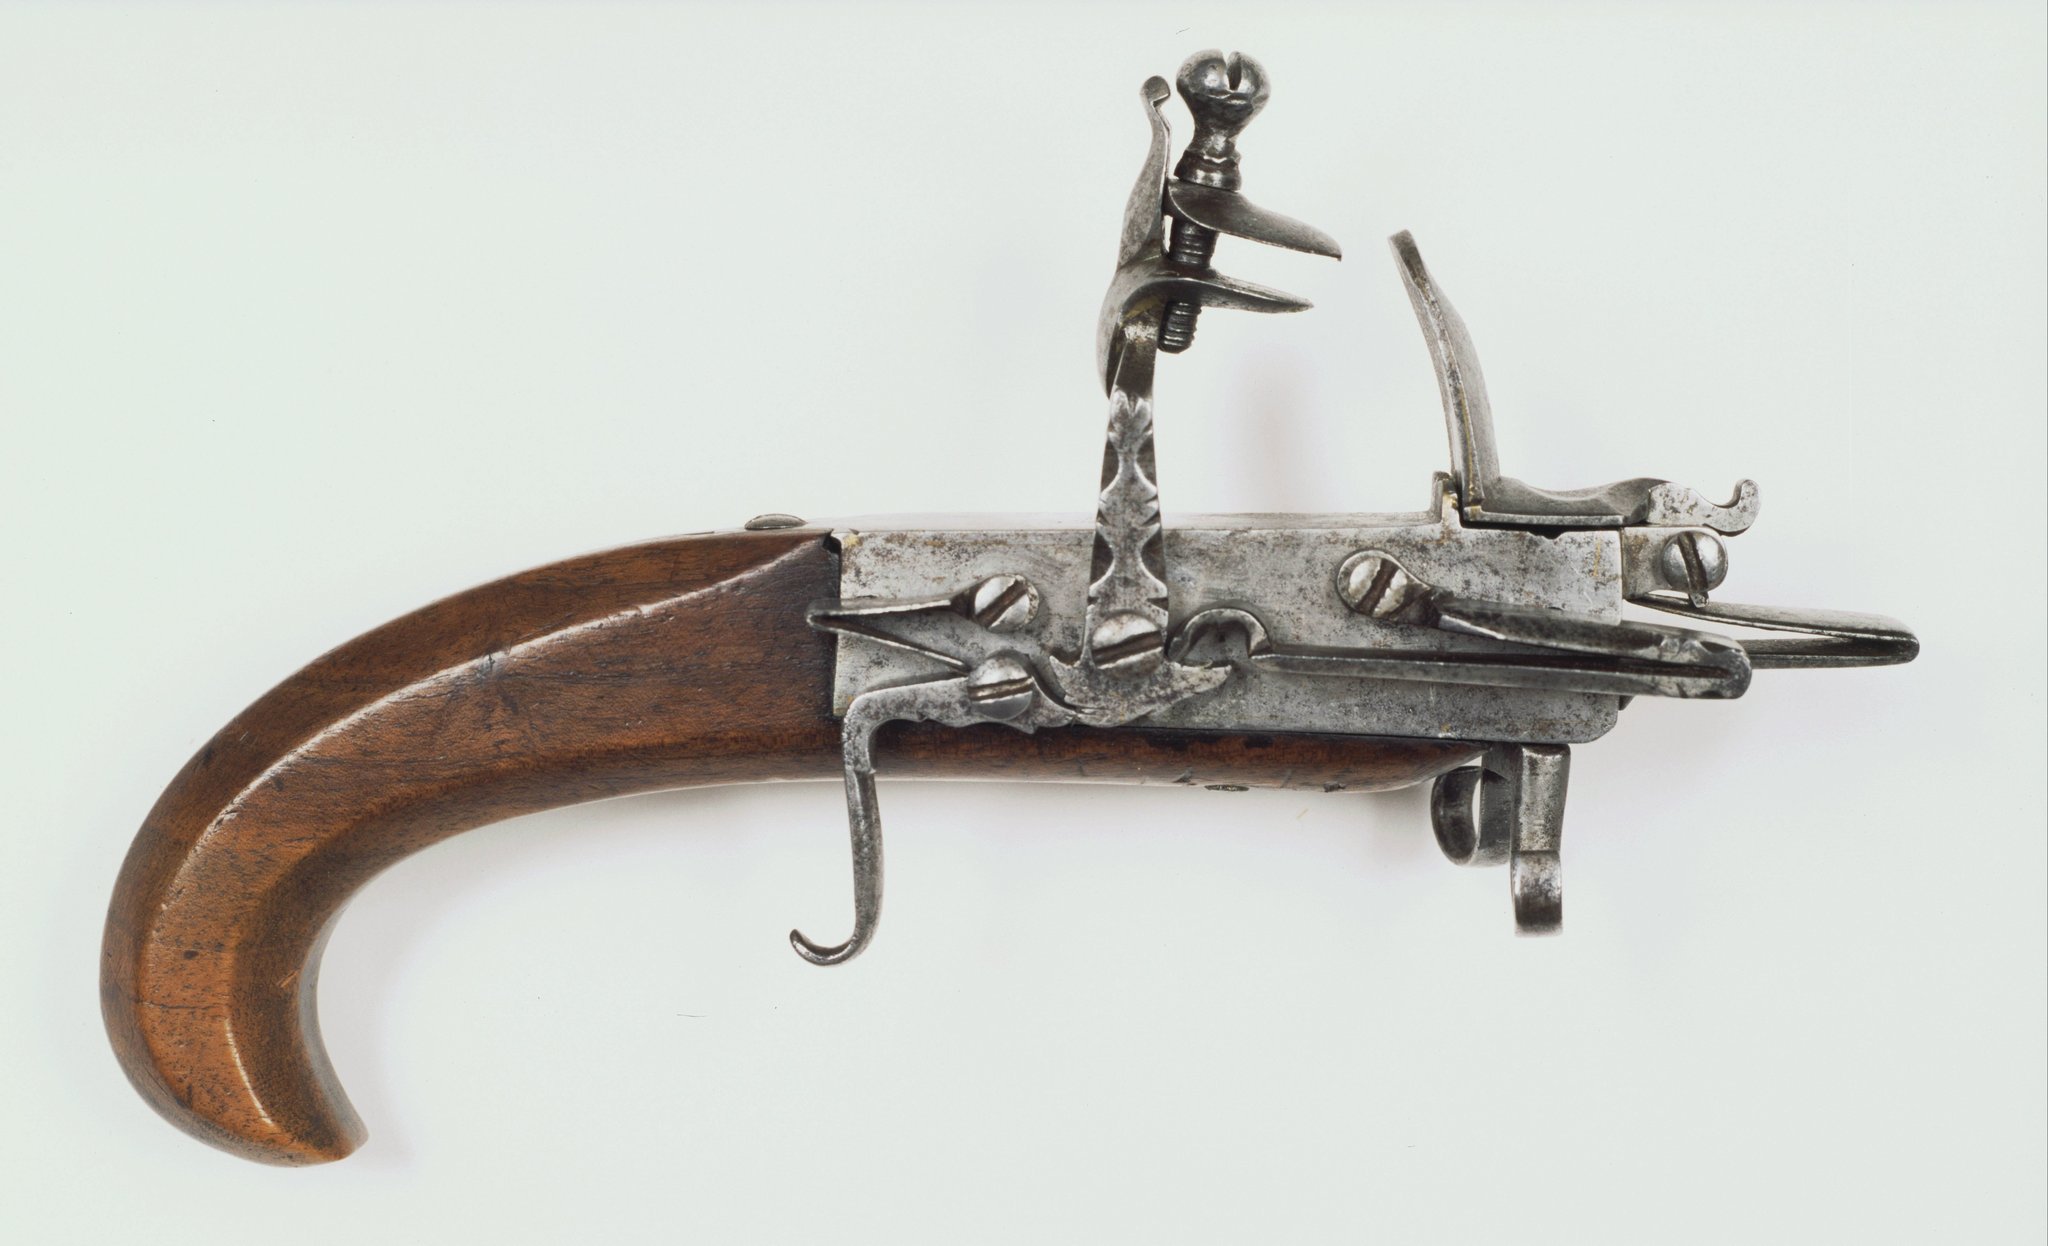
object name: firesteel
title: Pistool-tondeldoos met vuursteenslot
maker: Anonymous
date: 1750-1850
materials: iron, wood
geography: gorinchem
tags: gorinchem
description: Tondeldoos met ijzeren rechthoekige lade die zijwaarts geopend kan worden en houten gladde kolf die in een punt eindigt, voorts is deze in diverse vlakken gesneden. De haan is van ijzer en heeft op de kop een ronde pin die aangedraaid kan worden om de vuursteen goed te kunnen klemmen, het vuurstaal is van ijzer en hangt boven een ronde opening waar de tondel in werd geplaatst. Het voetstuk van de tondeldoos is van ijzer en heeft twee gekrulde poten waar de tondeldoos op kan rusten. De trekker is van ijzer en heeft een kleine buiging zodat de vinger beter grip heeft, voorts is deze uitwendig geplaatst naast de rechthoekige ijzeren lade.